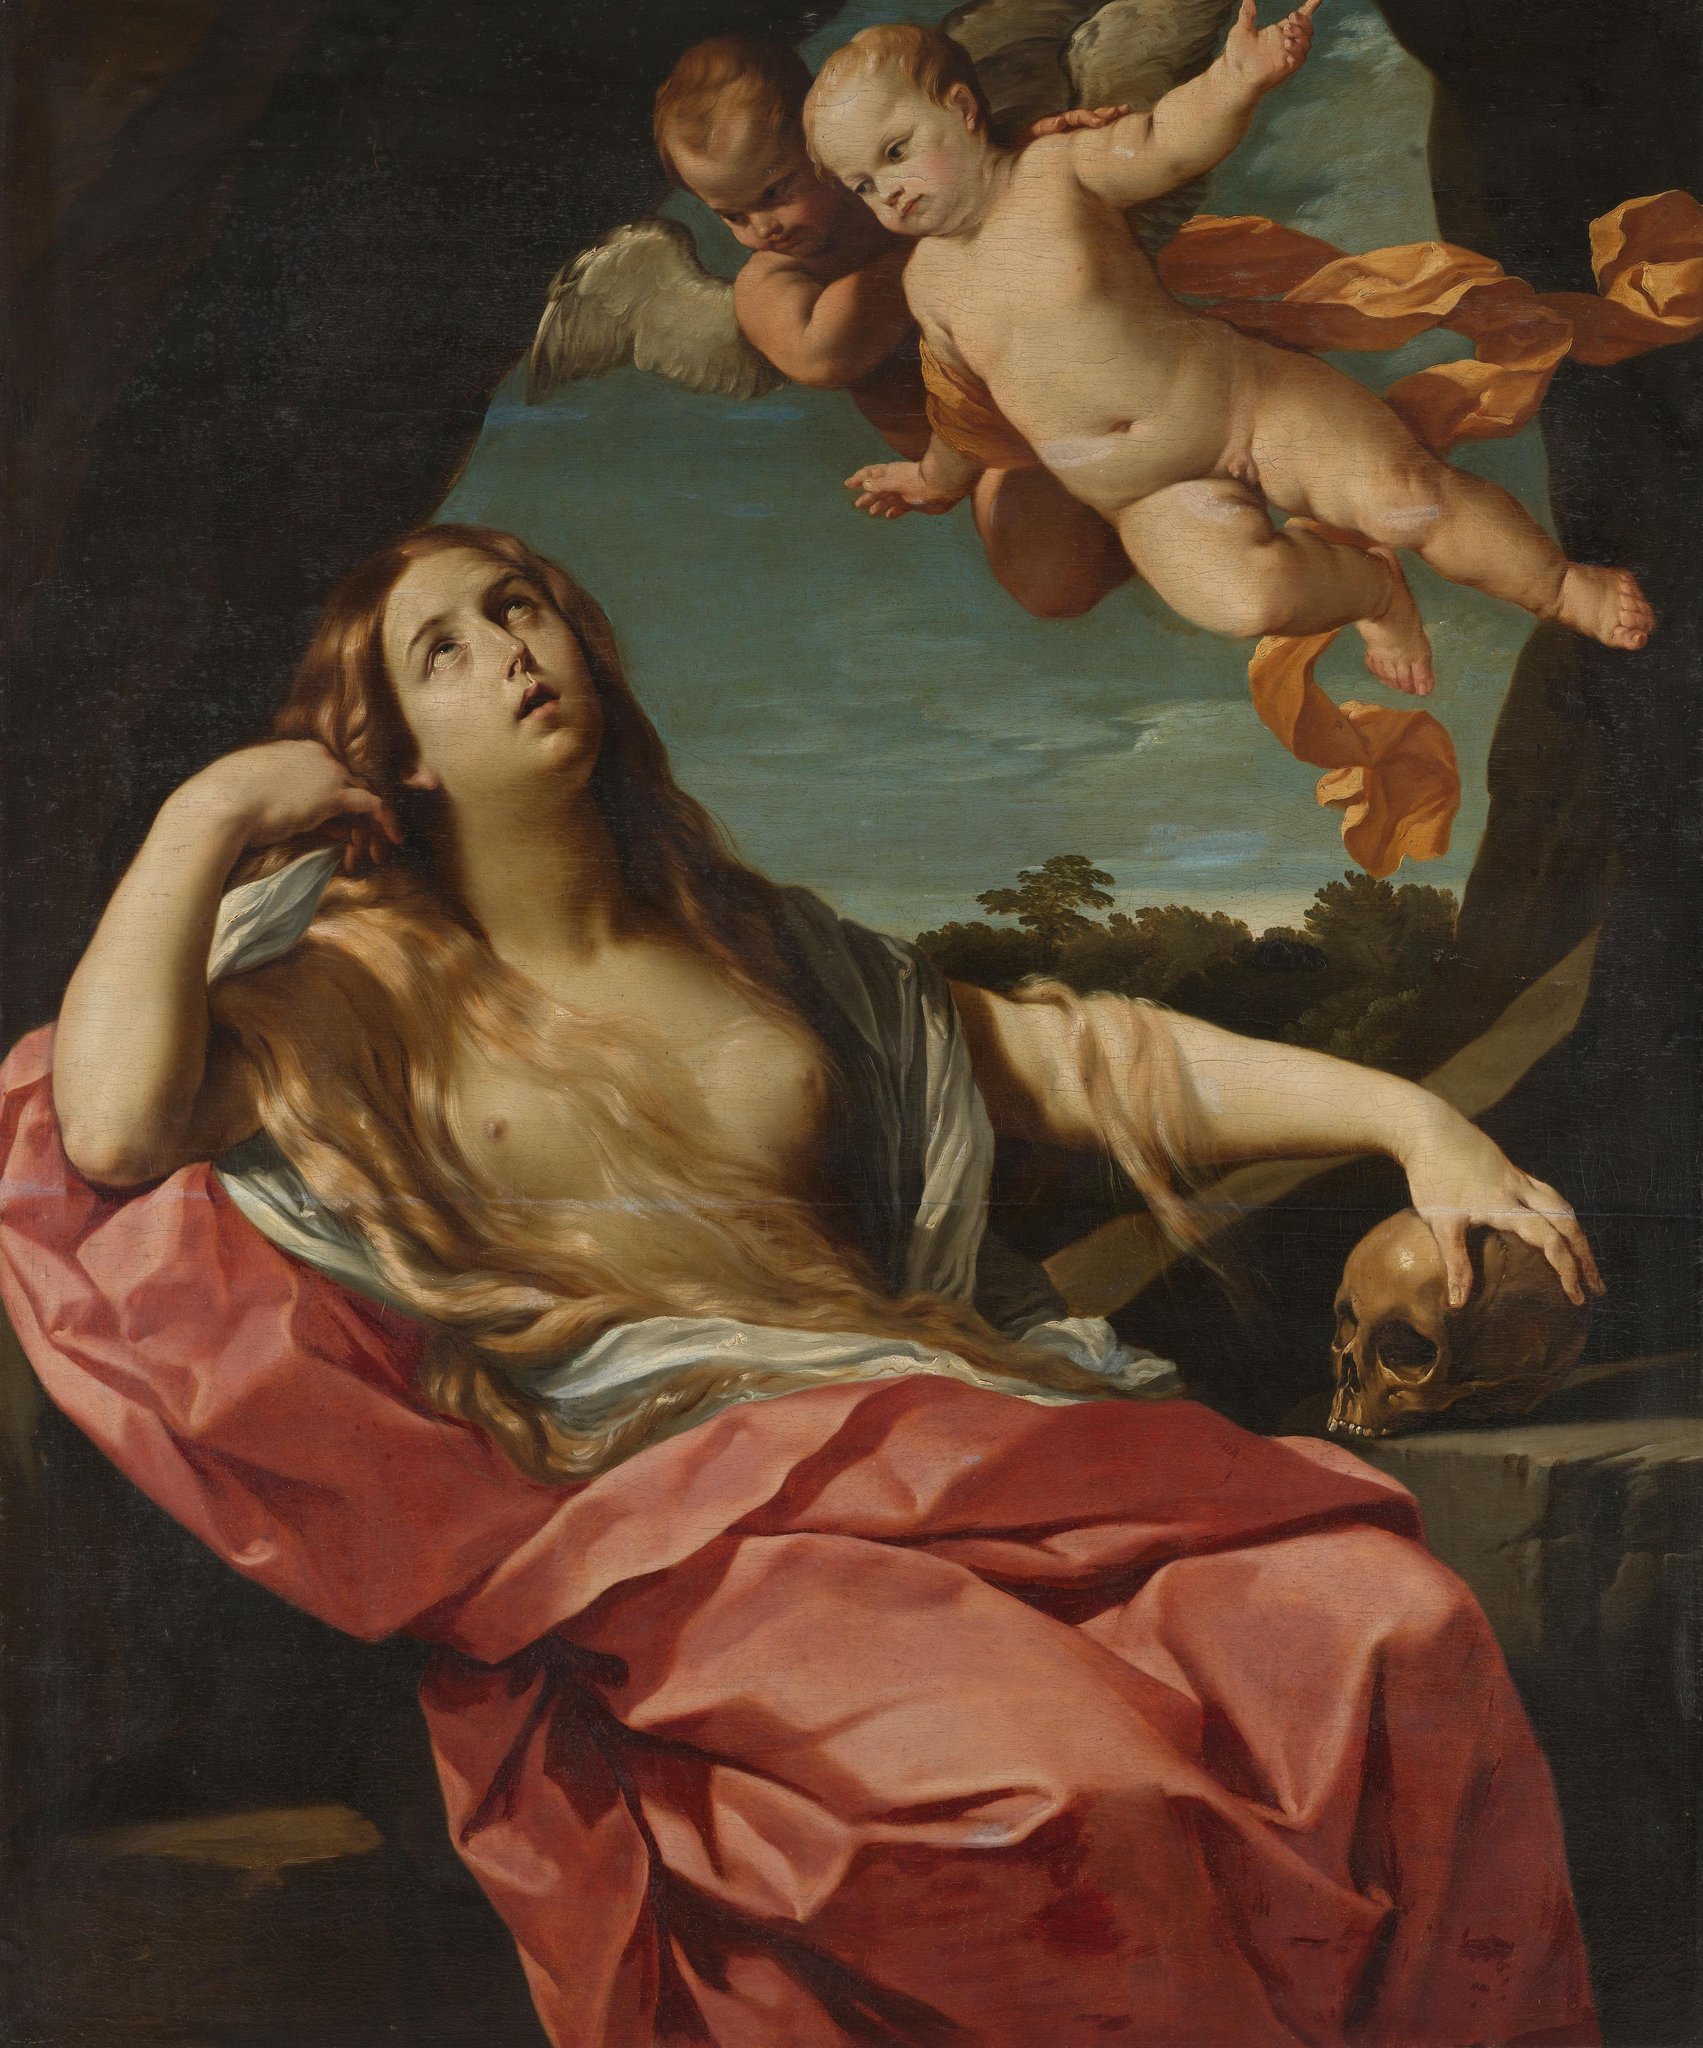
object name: painting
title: Mary Magdalene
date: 1627-1720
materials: canvas, oil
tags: the penitent st. mary magdalene (often before a cave, possibly at la sainte-baume hill): her long hair covers her (naked) body, she reads, meditates or raises her tear-filled eyes towards heaven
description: Maria Magdalena, zittend tussen rotsen, met ontblote boezem en met de linkerhand op een schedel. Boven twee putti. Kopie naar het origineel in een privé collectie te Rome.